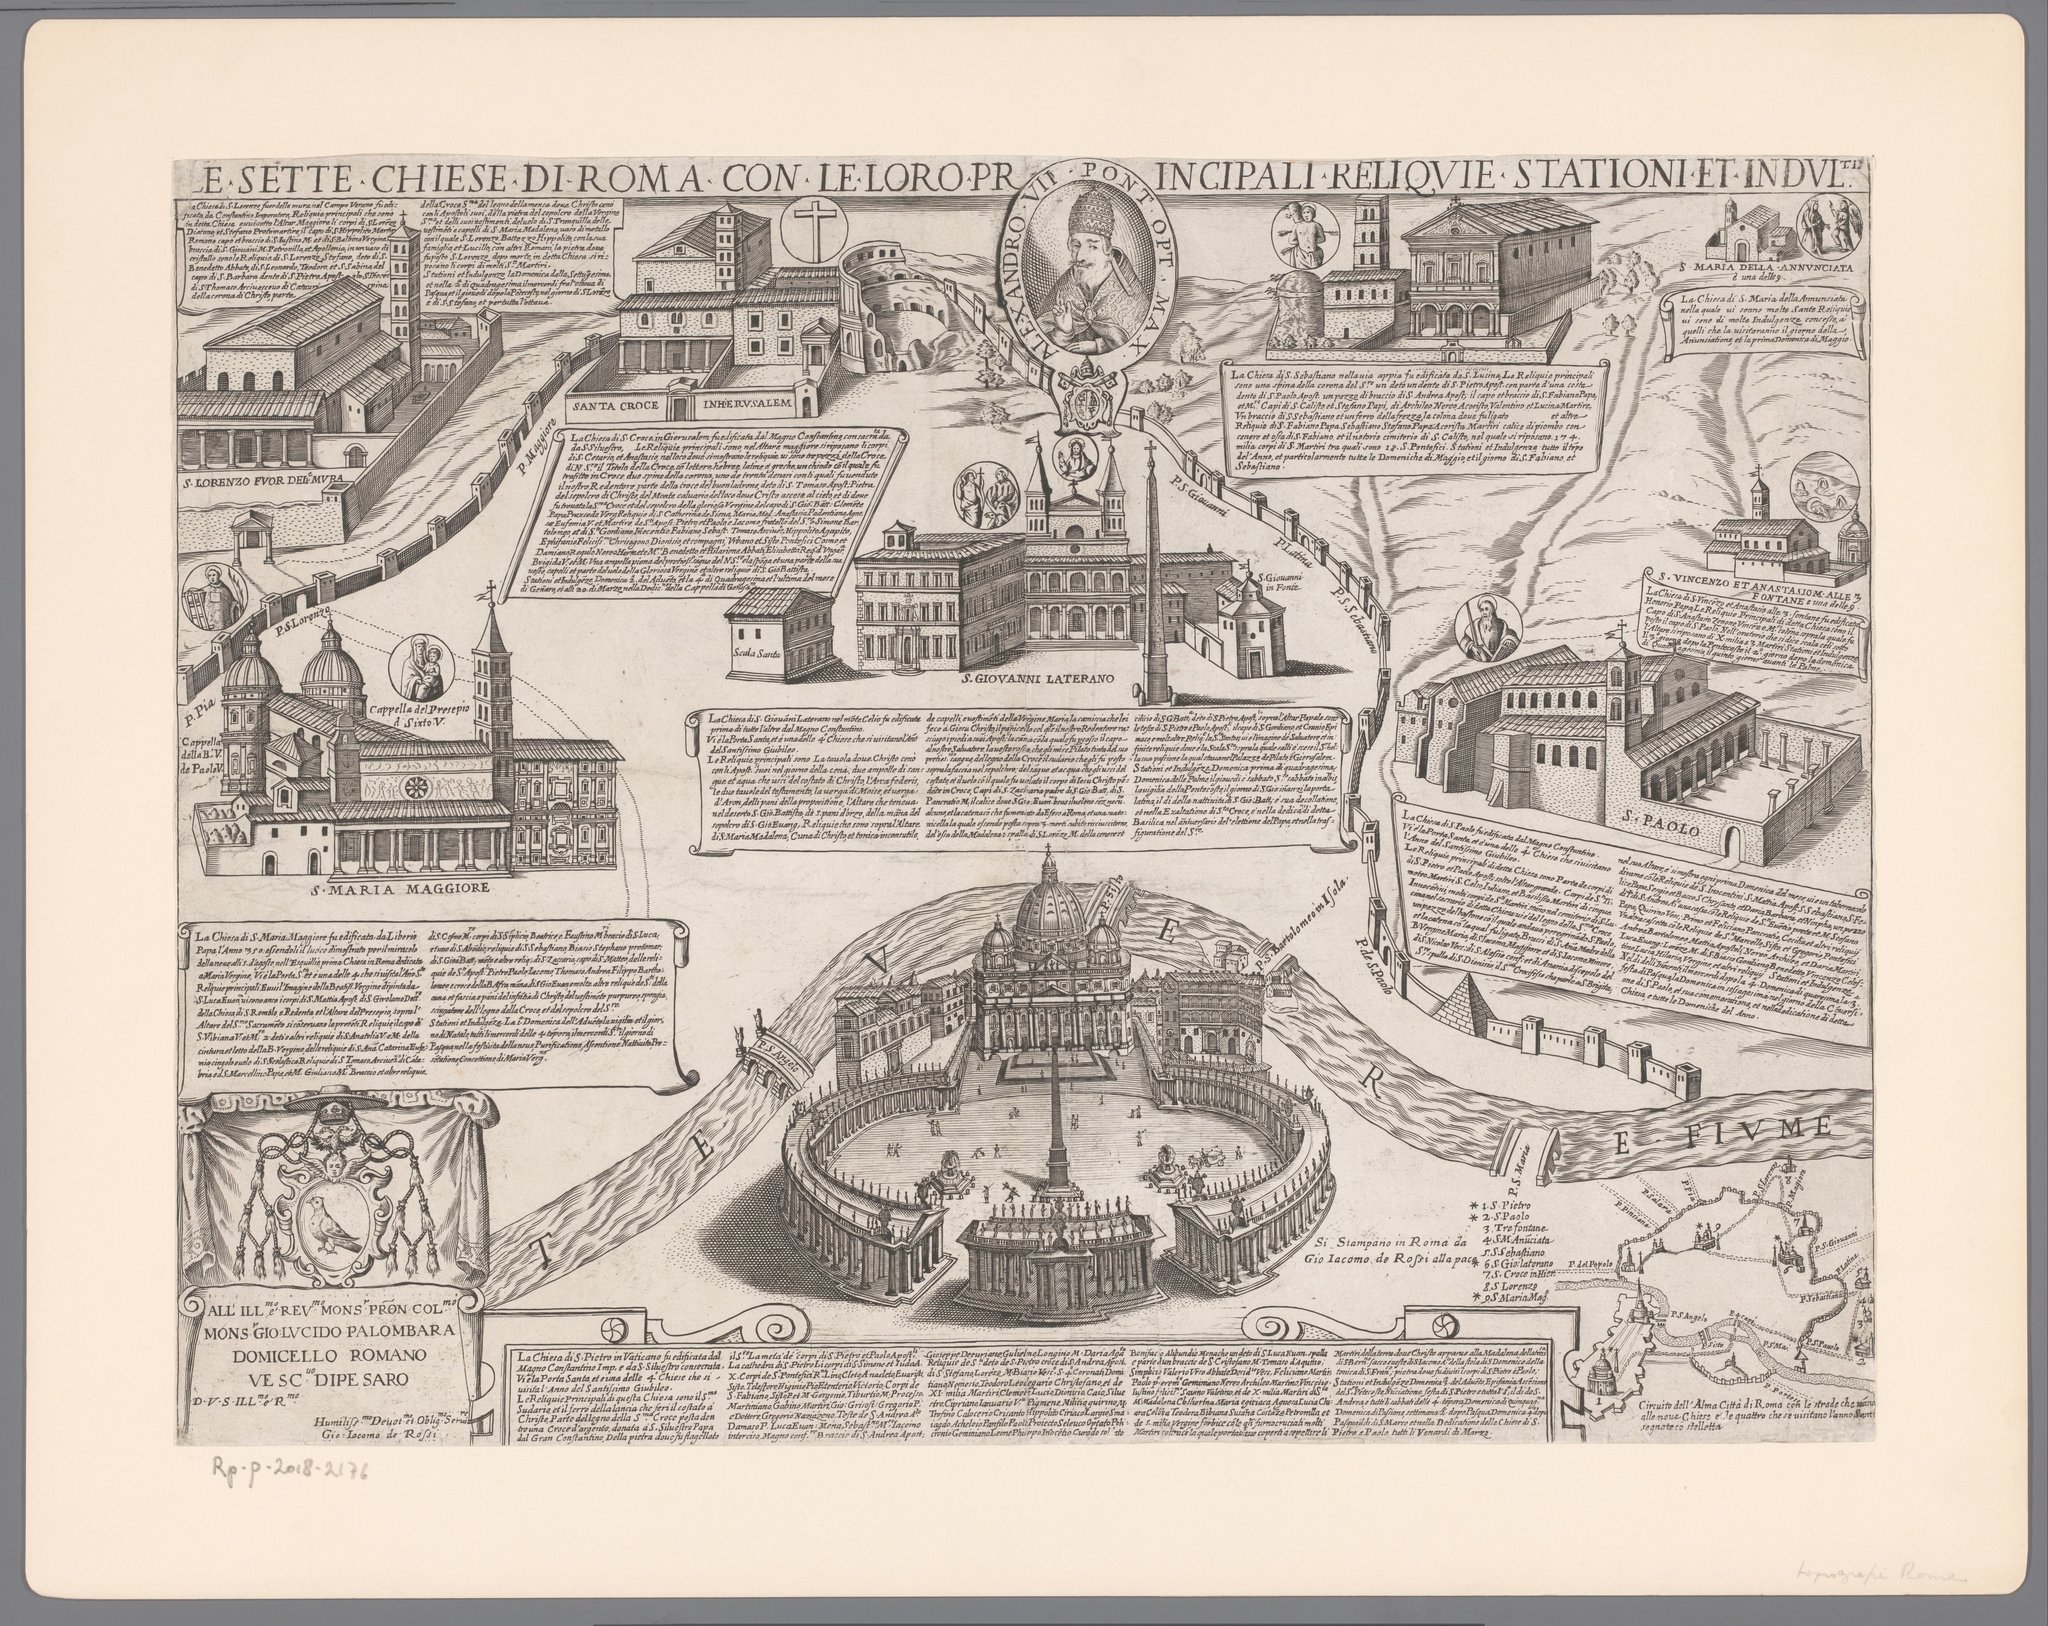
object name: print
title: Le sette chiese di Roma con le loro principali reliquie stationi et indultie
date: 1658-1666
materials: paper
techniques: engraving, etching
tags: church (exterior), armorial bearing, heraldry, rome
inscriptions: collector's mark: Lugt 2228